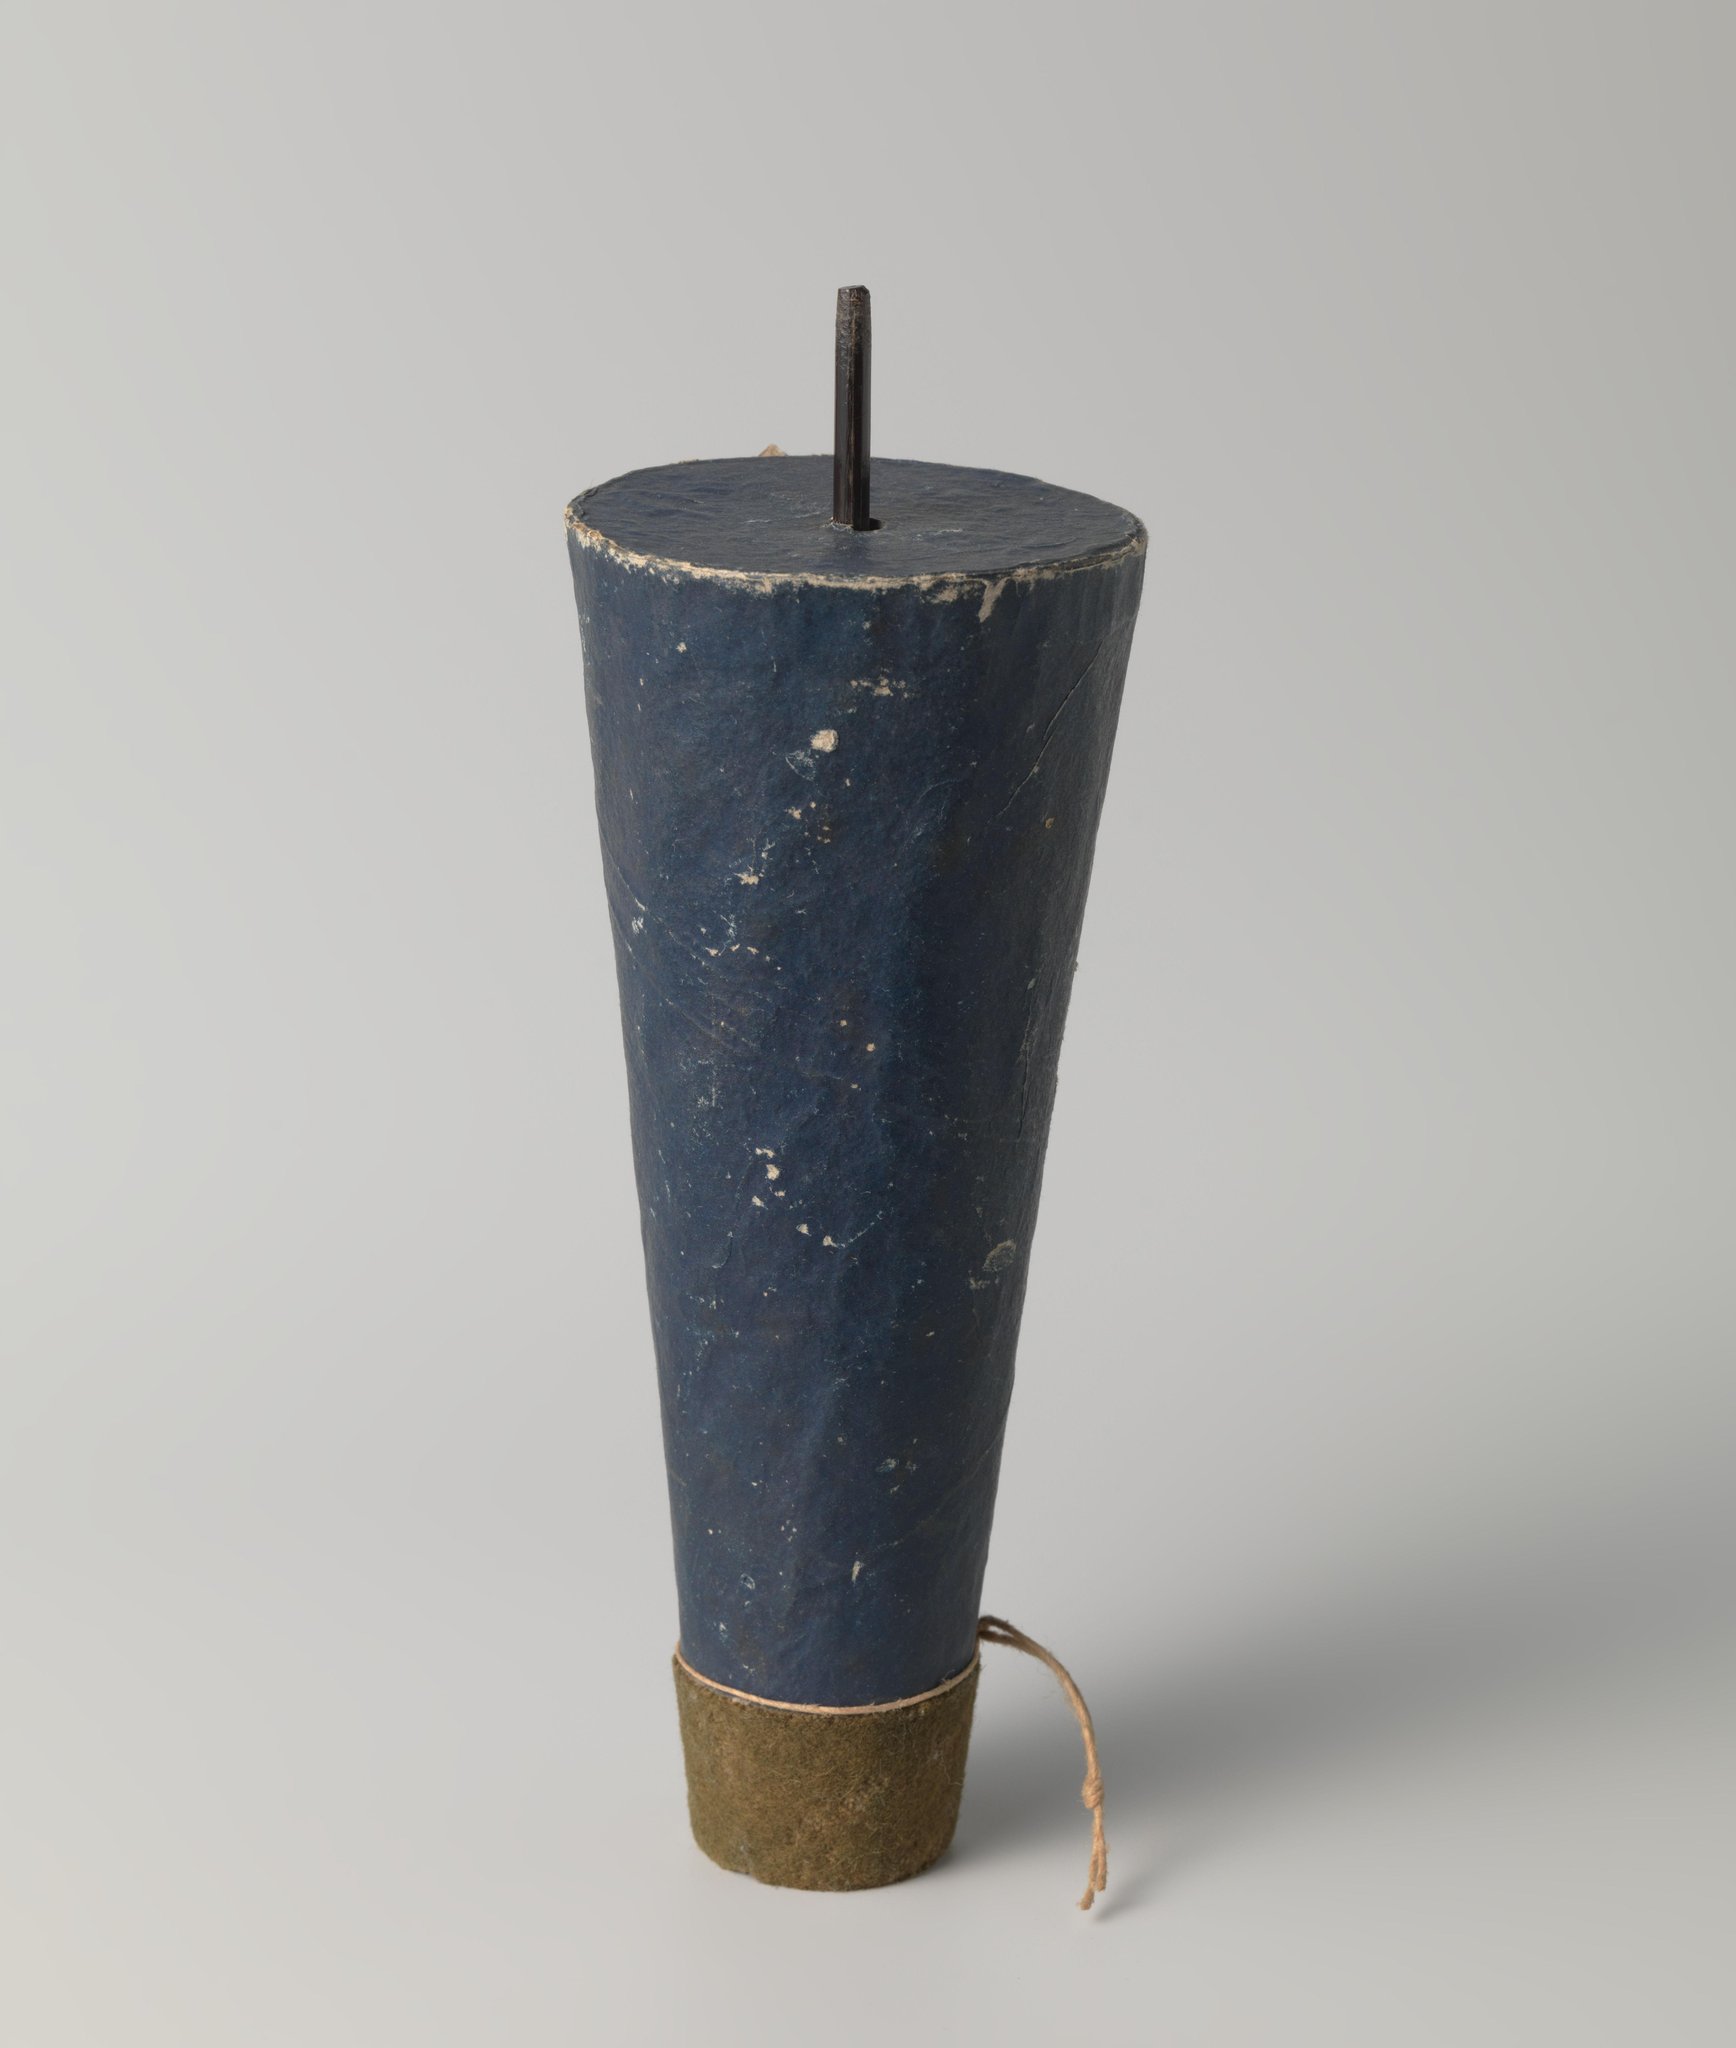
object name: mute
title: French horn mute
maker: Anonymous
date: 1824-1850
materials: cardboard, metal, paper, fiber, wool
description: Demper voor een hoorn gemaakt van karton, blauw papier, groen gevilte stof, touw en metaal. Behorend bij waldhoorn met invnr. BK-NM-11430-36.